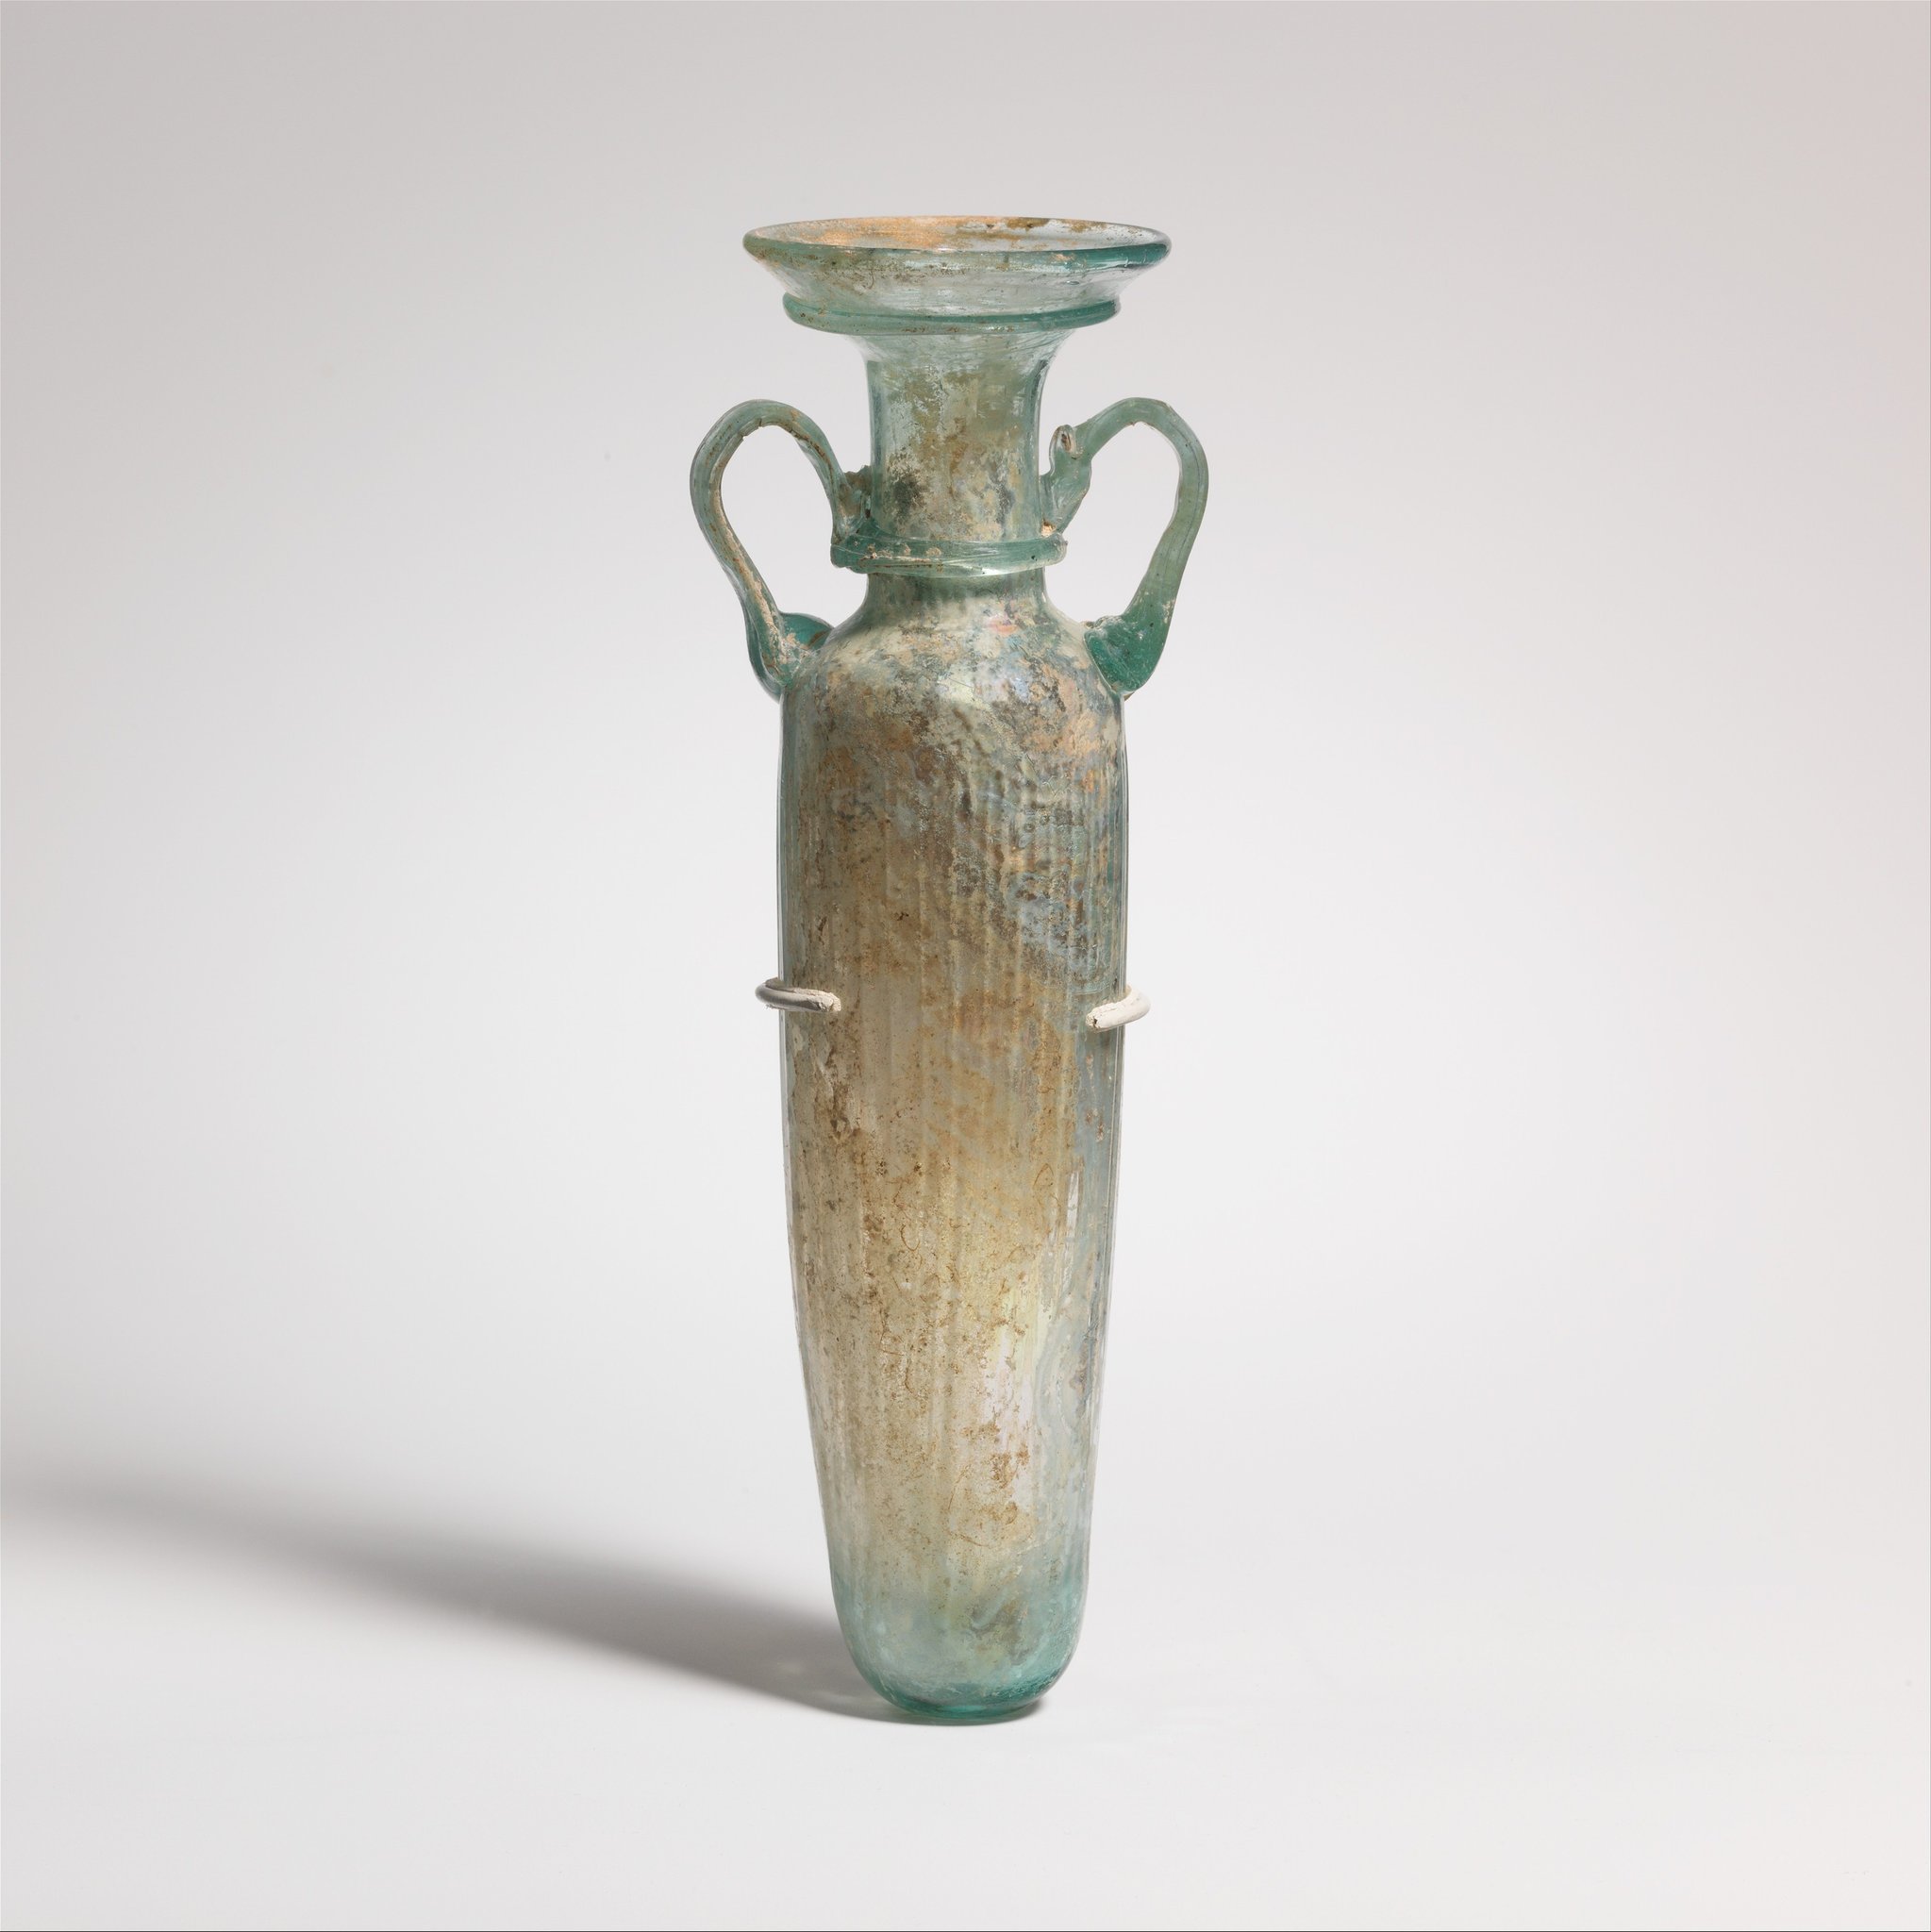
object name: amphoriskos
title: Glass bottle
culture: roman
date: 301-500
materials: glass